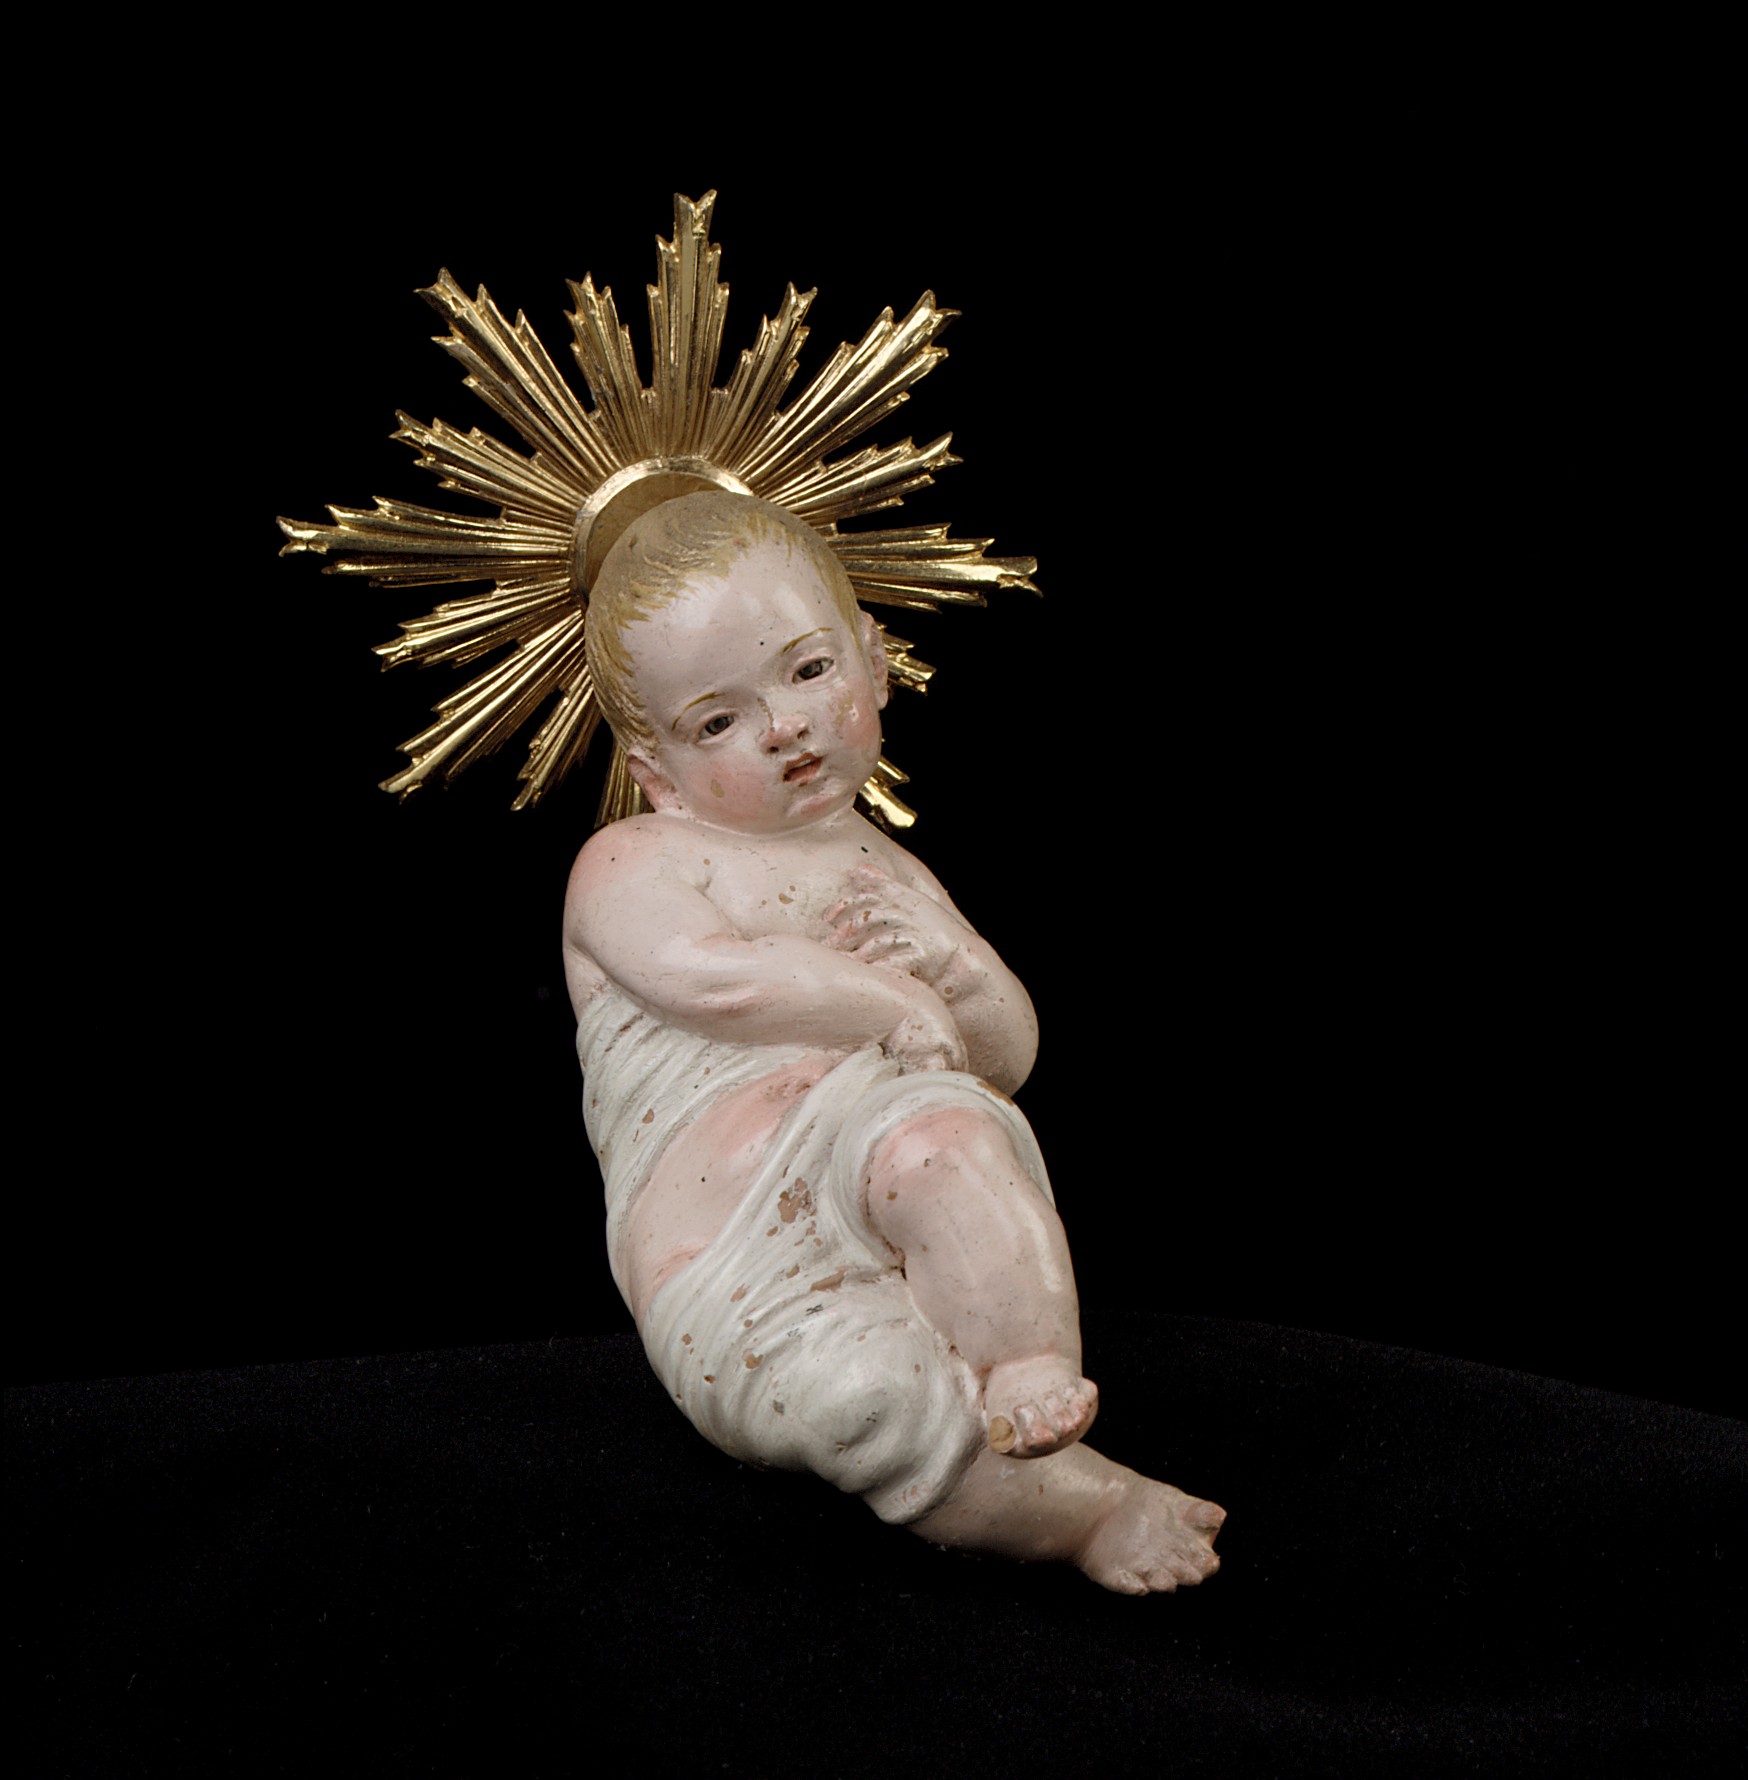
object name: crèche figure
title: Infant Jesus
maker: giuseppe sanmartino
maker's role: maker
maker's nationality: italian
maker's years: 1720-1793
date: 1751-1800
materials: fiber, silver gilt, terracotta, wood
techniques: polychrome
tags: infants,jesus